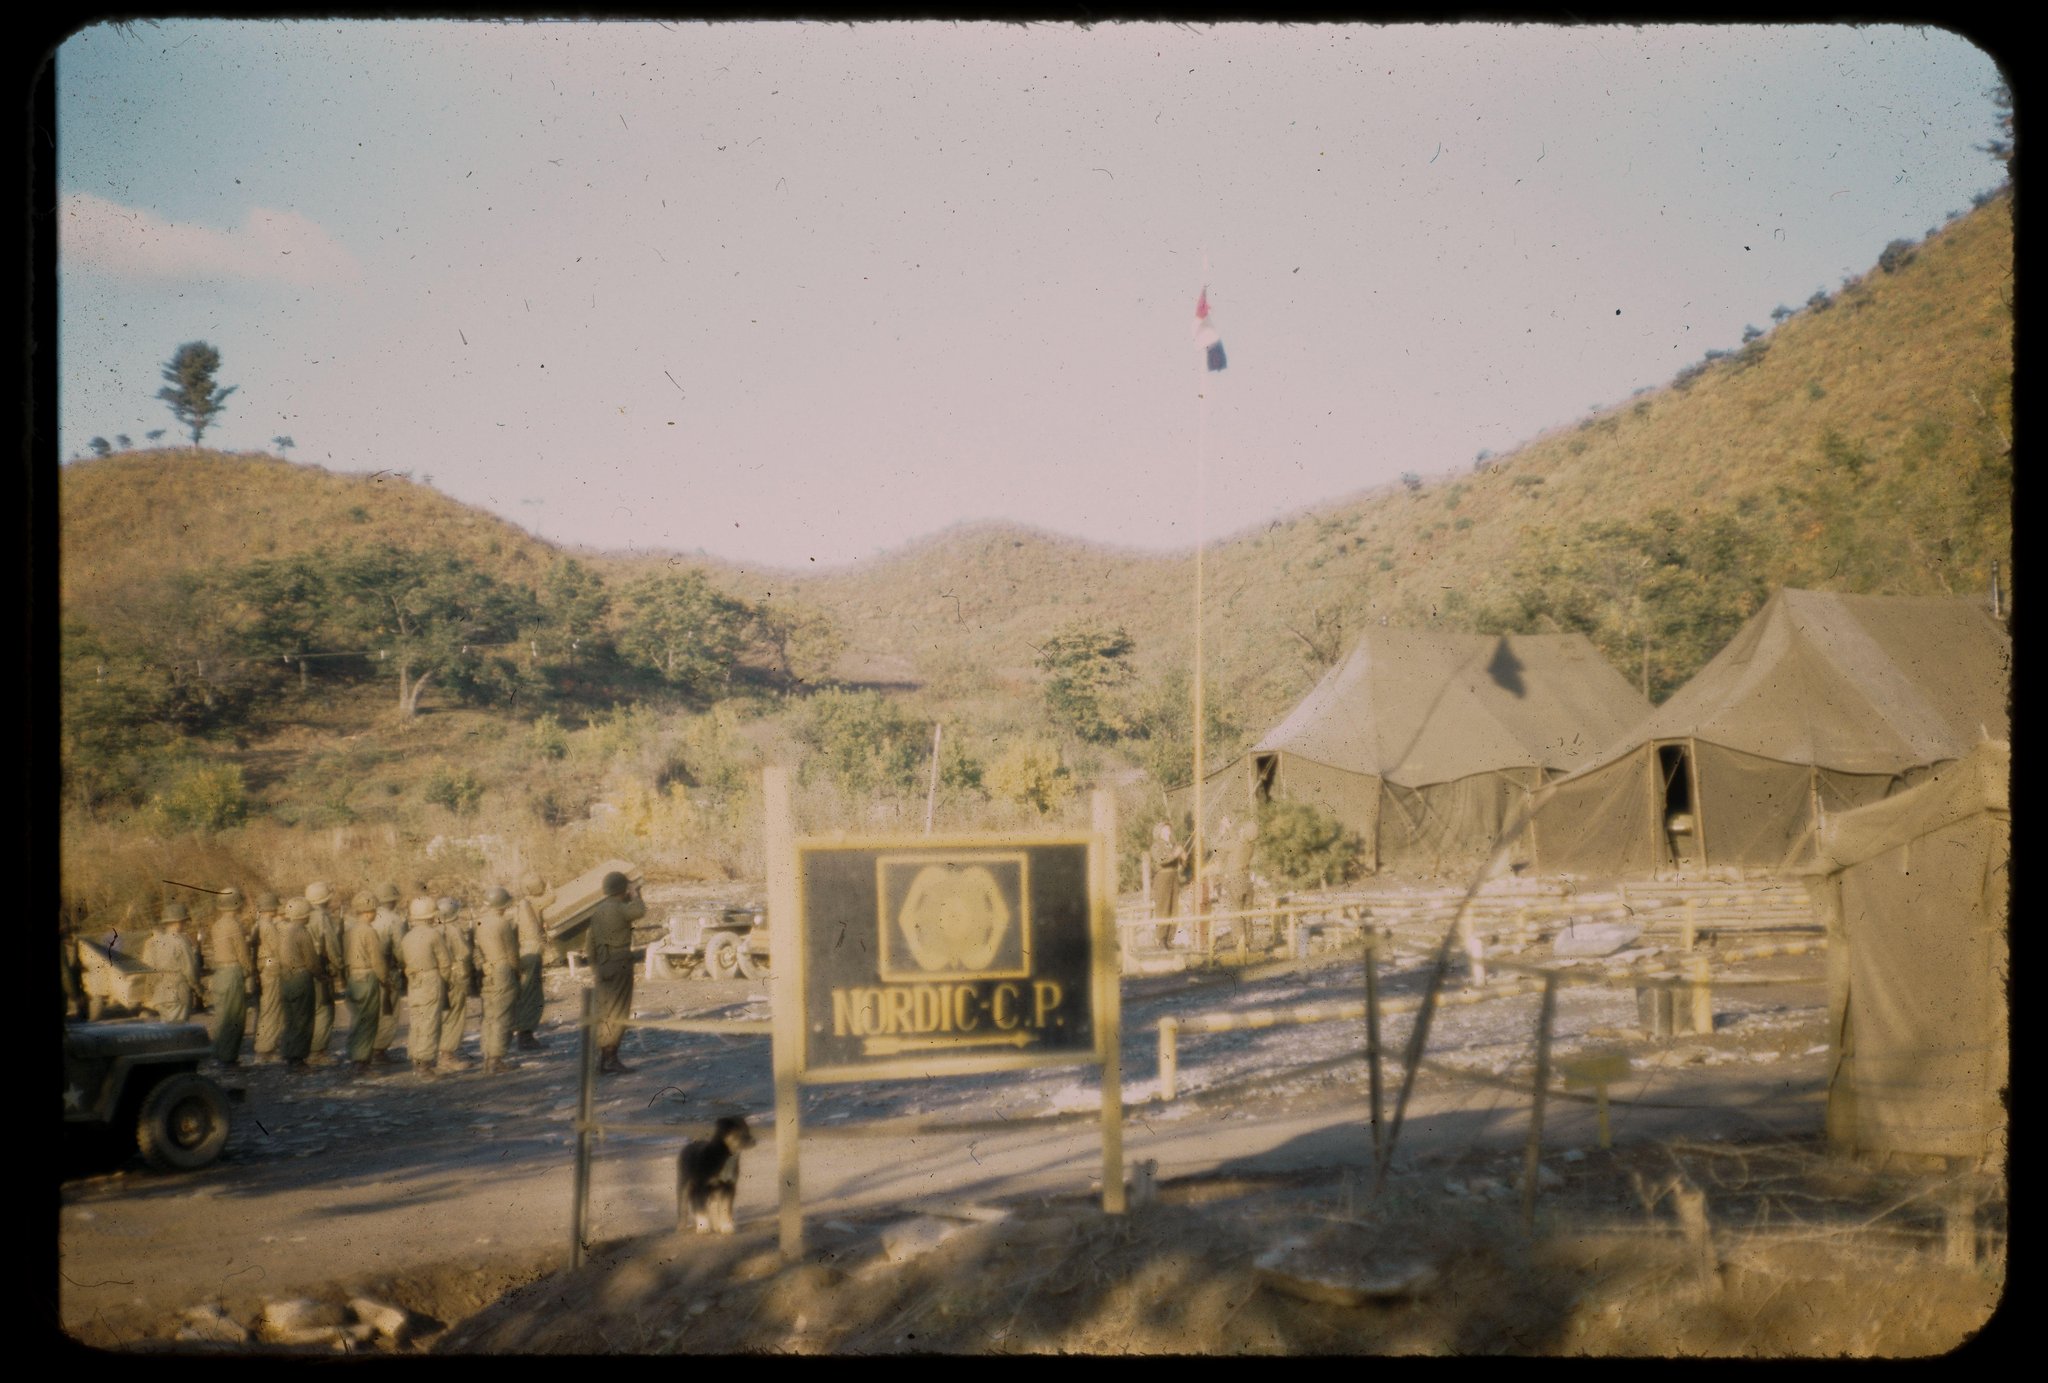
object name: color slide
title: Oorlog in Korea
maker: david ketel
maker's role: diplomaat, sinoloog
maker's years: 1913-2008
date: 1952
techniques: slide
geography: korea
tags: united nations